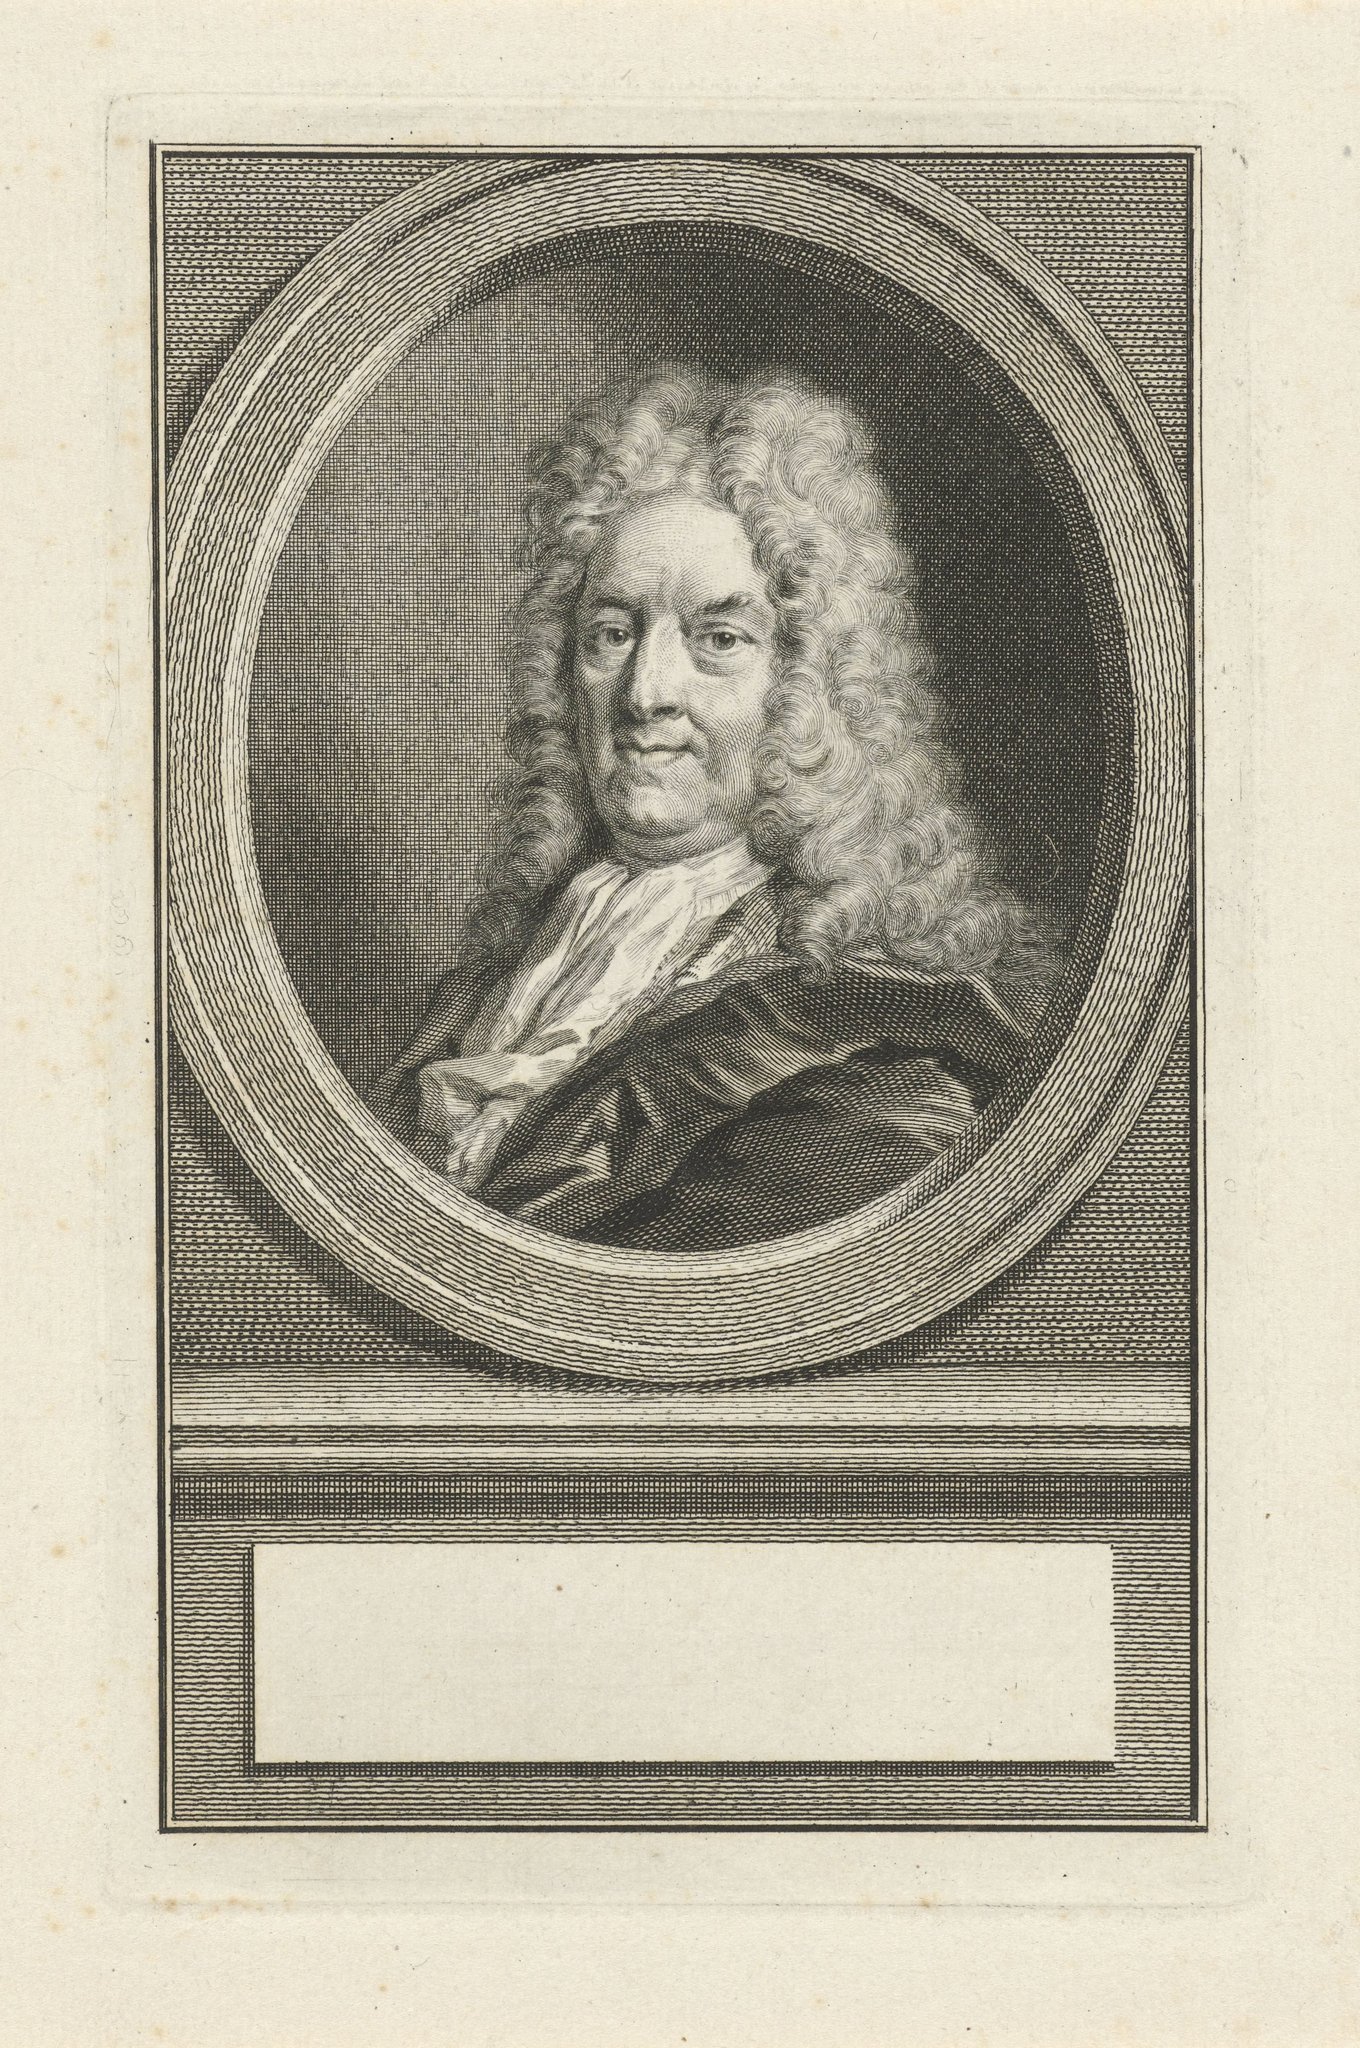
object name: print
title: Portret van Jacob Hop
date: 1747-1759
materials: paper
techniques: engraving, etching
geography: amsterdam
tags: jacob hop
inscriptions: collector's mark: Lugt 2228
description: Proefdruk van de prent gebruikt in: Jan Wagenaar, Vaderlandsche historie, vervattende de geschiedenissen der nu Vereenigde Nederlanden, inzonderheid die van Holland (...), 21 delen. Amsterdam, Isaak Tirion, 1749-59.